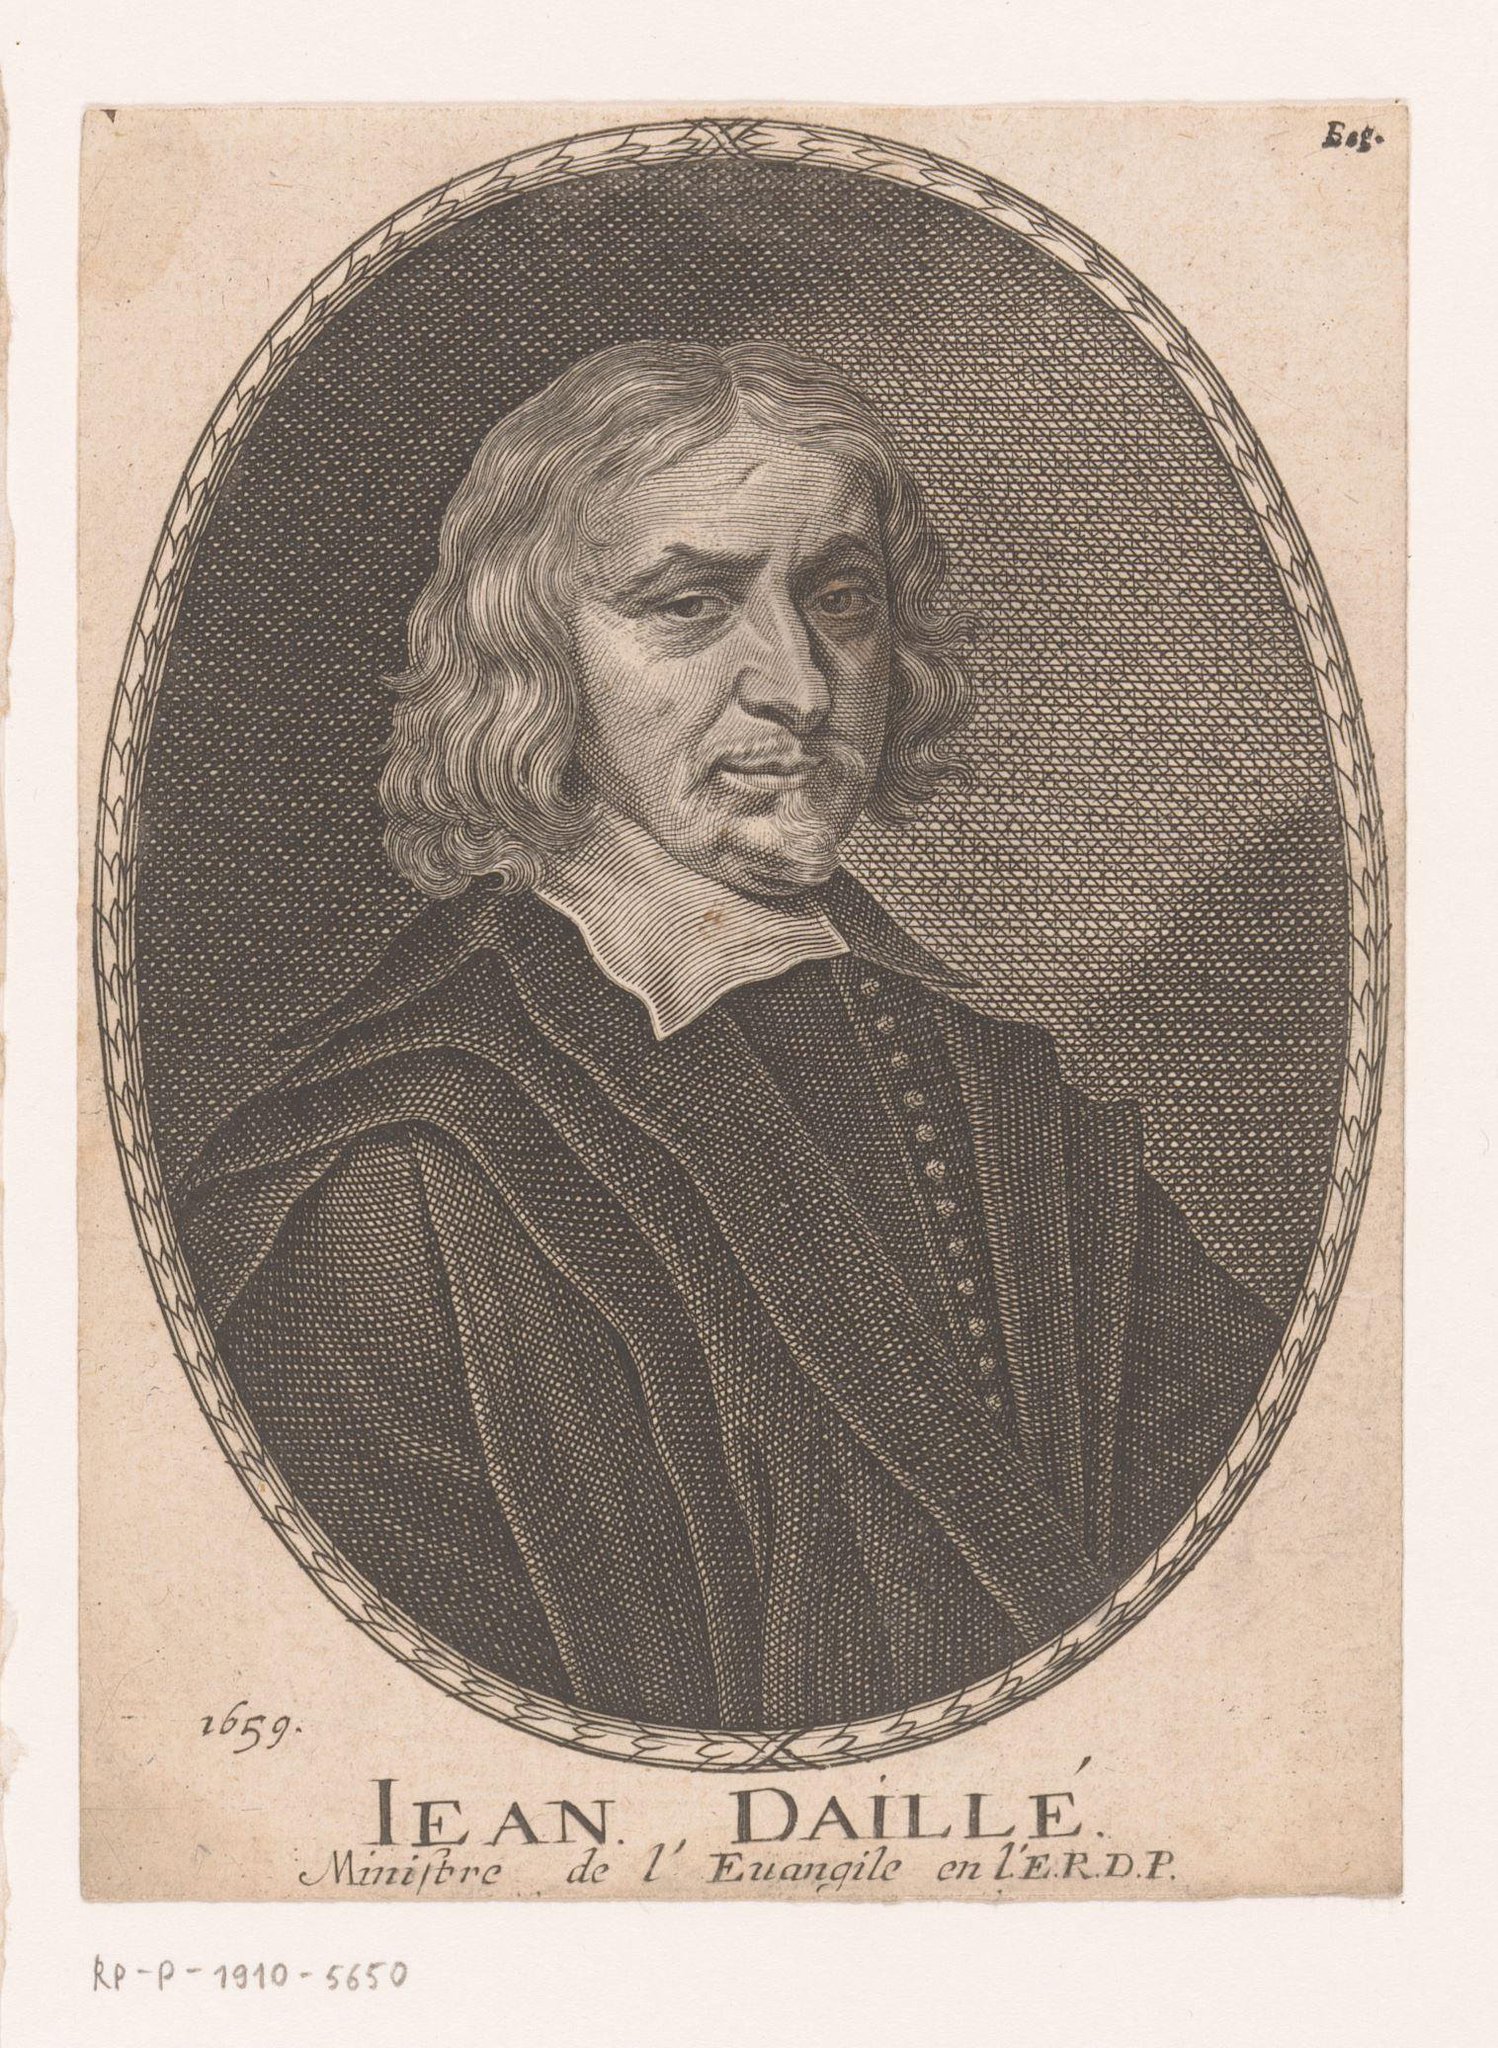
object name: print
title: Portret van Jean Daillé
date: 1659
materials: paper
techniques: engraving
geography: paris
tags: paris, historical persons, politician, e.g. party leader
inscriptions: collector's mark: Lugt 2228